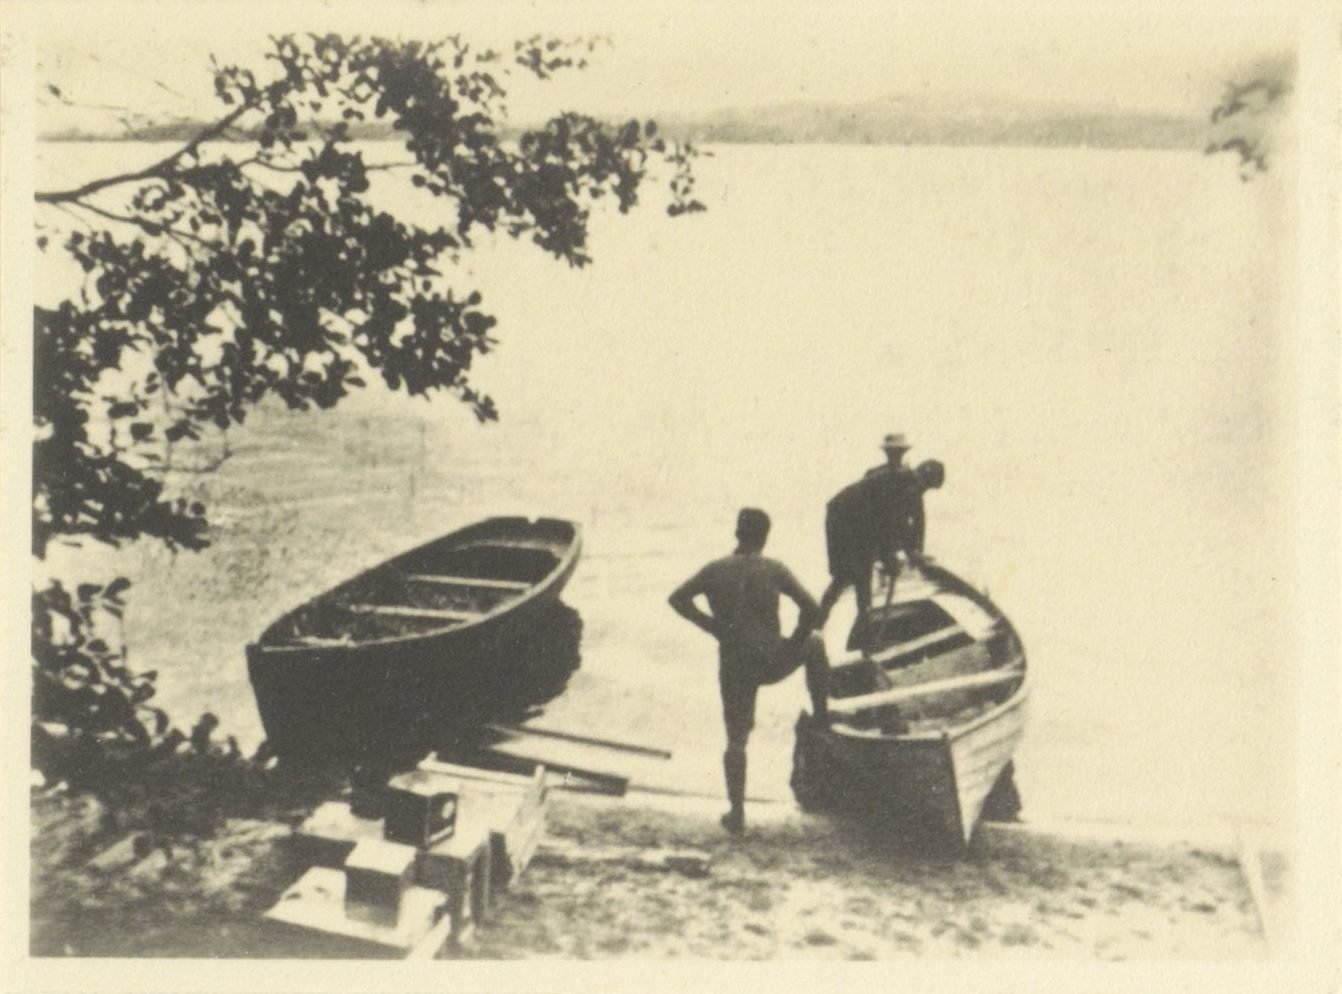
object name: photograph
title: Leerlingen van Schule Schloss Salem tijdens een boottocht op Finse meren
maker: Anonymous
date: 1925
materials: photographic support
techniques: gelatin silver print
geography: finland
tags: rowing-boat, canoe, etc., education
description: Onderdeel van Fotoalbum van Schule Schloss Salem.